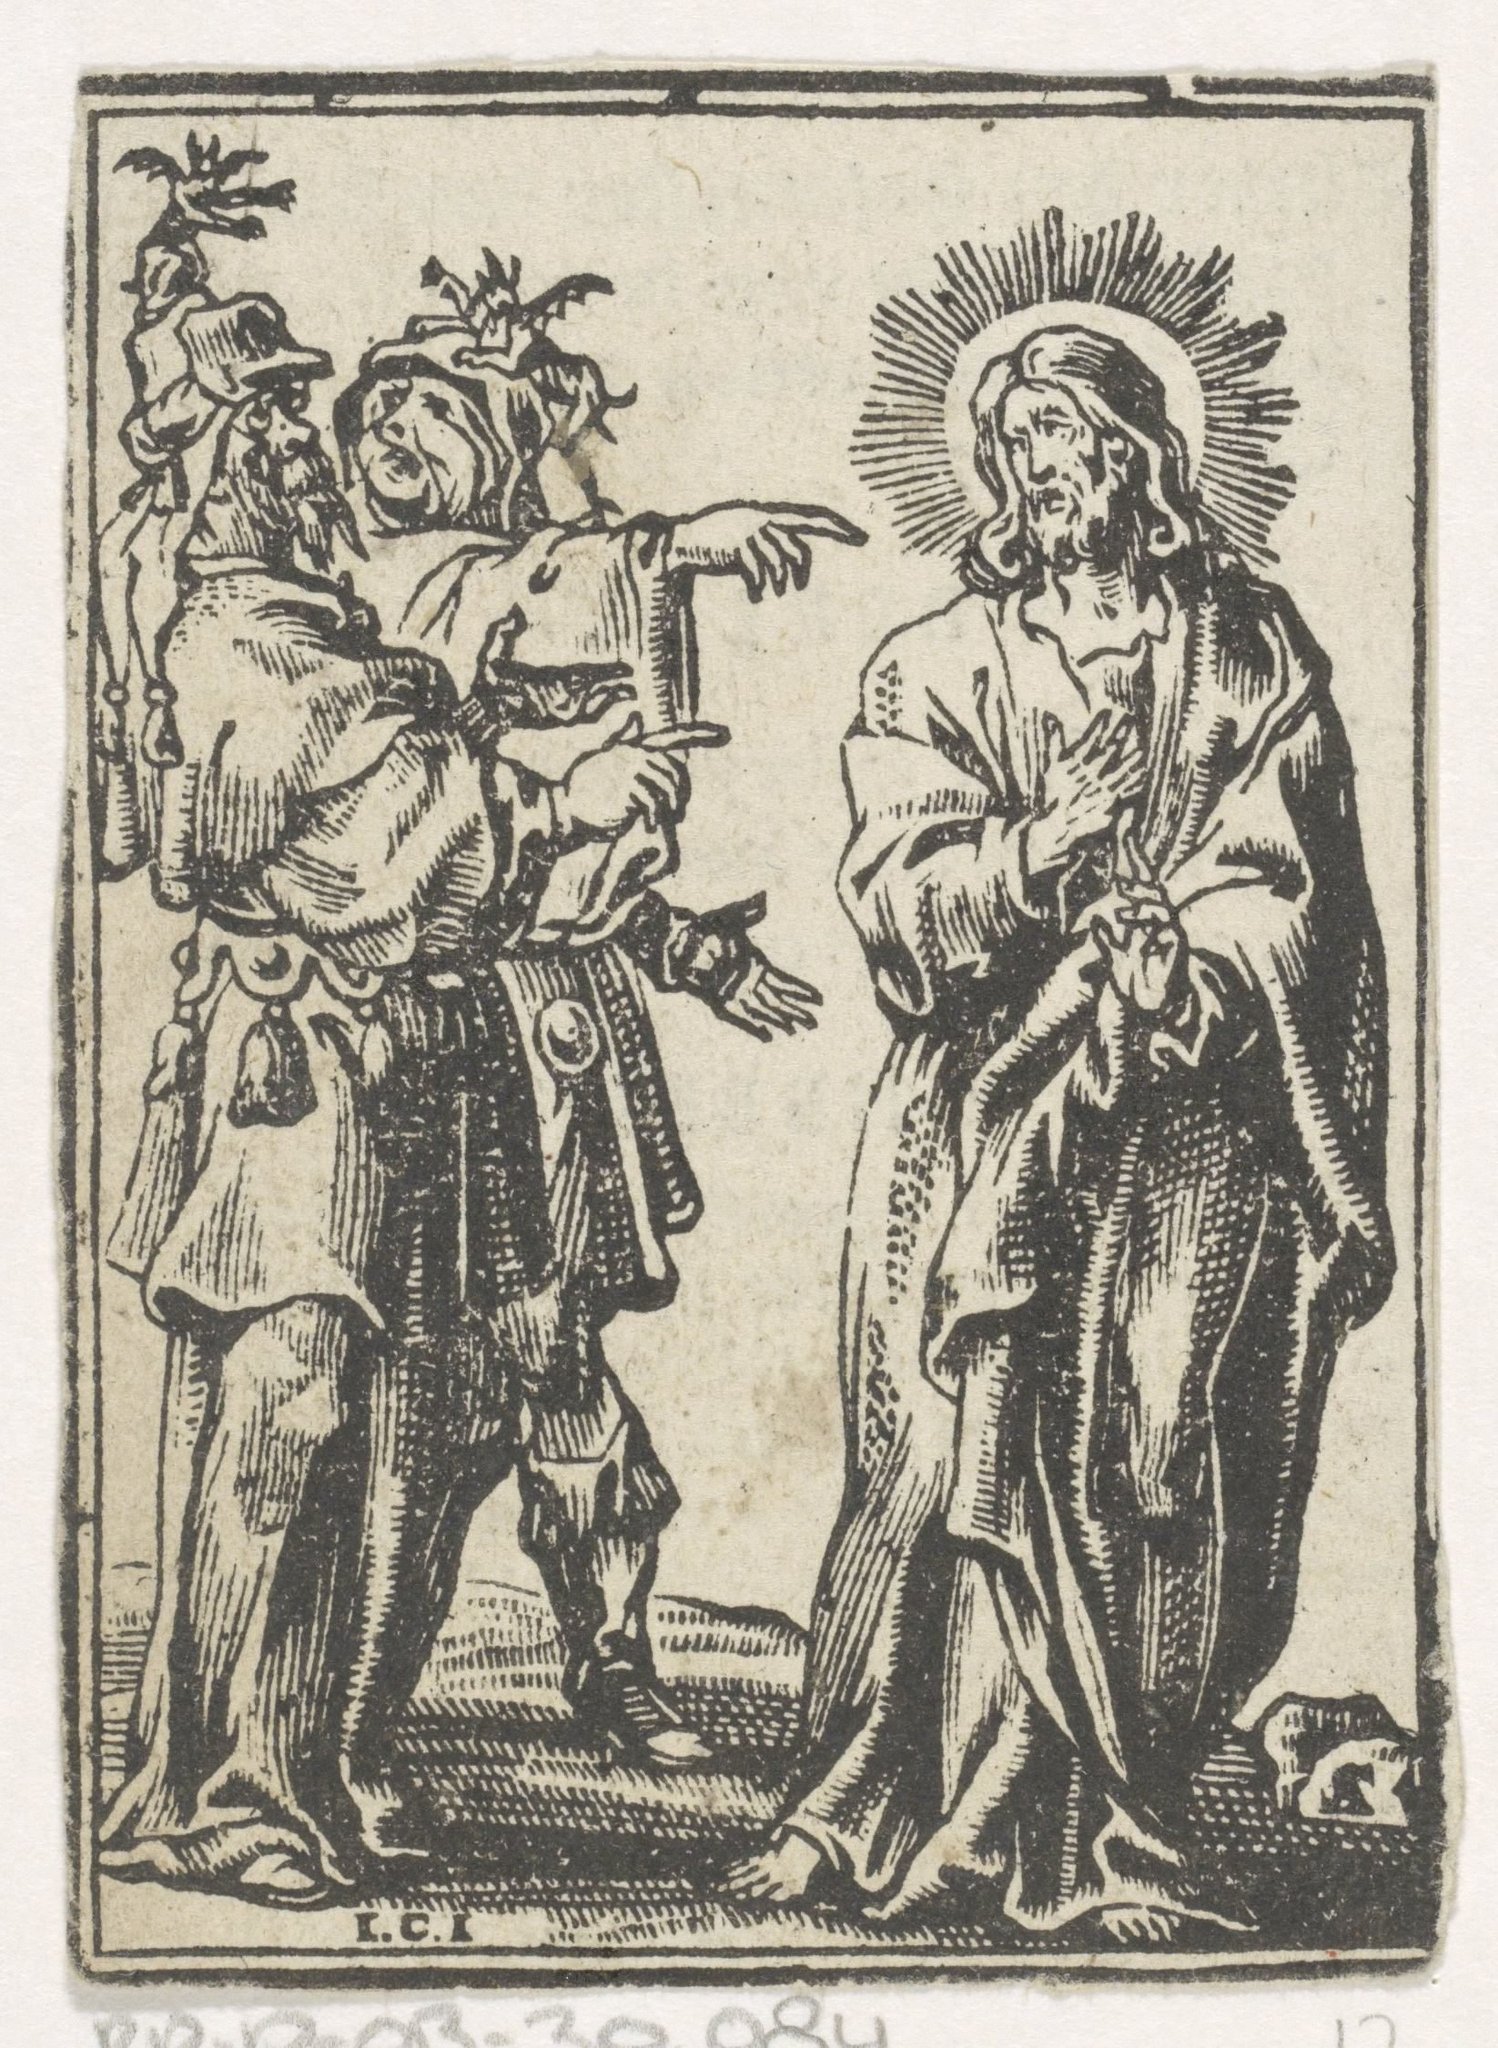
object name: book illustration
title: Christus geneest twee bezetenen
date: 1649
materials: paper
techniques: letterpress printing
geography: antwerp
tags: healing of two (or one) possessed at gerasa (gadara) (matthew 8:28-34; mark 5:1-20; luke 8:26-39)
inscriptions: collector's mark: Lugt 240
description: Christus geneest met een zegenend gebaar twee bezetenen in het gebied van de Gerasenen. Hij drijft de demonen uit hun lichamen.